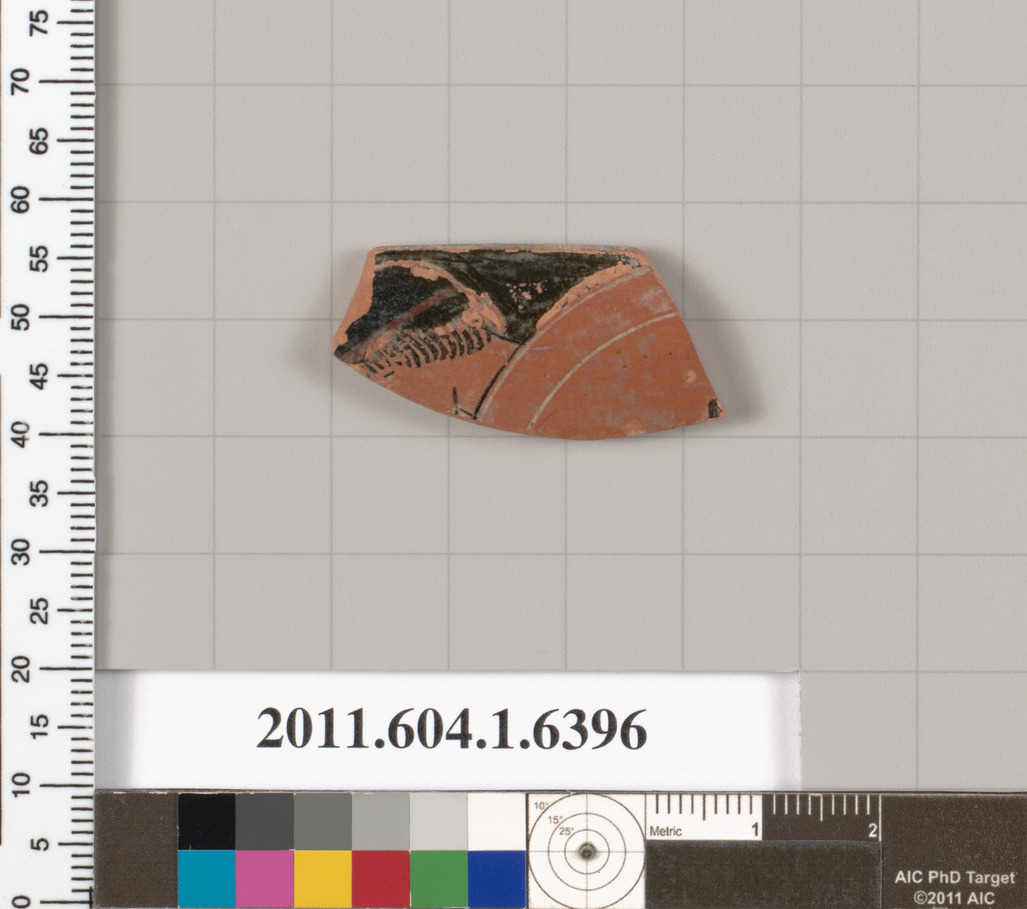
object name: kylix fragment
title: Terracotta rim fragment of a kylix (drinking cup)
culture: greek, attic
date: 490-480 BCE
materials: terracotta